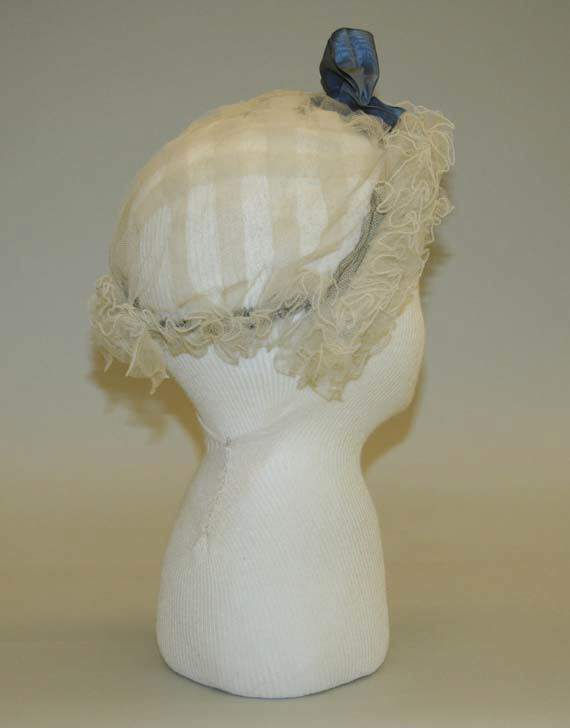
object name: cap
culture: american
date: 1840